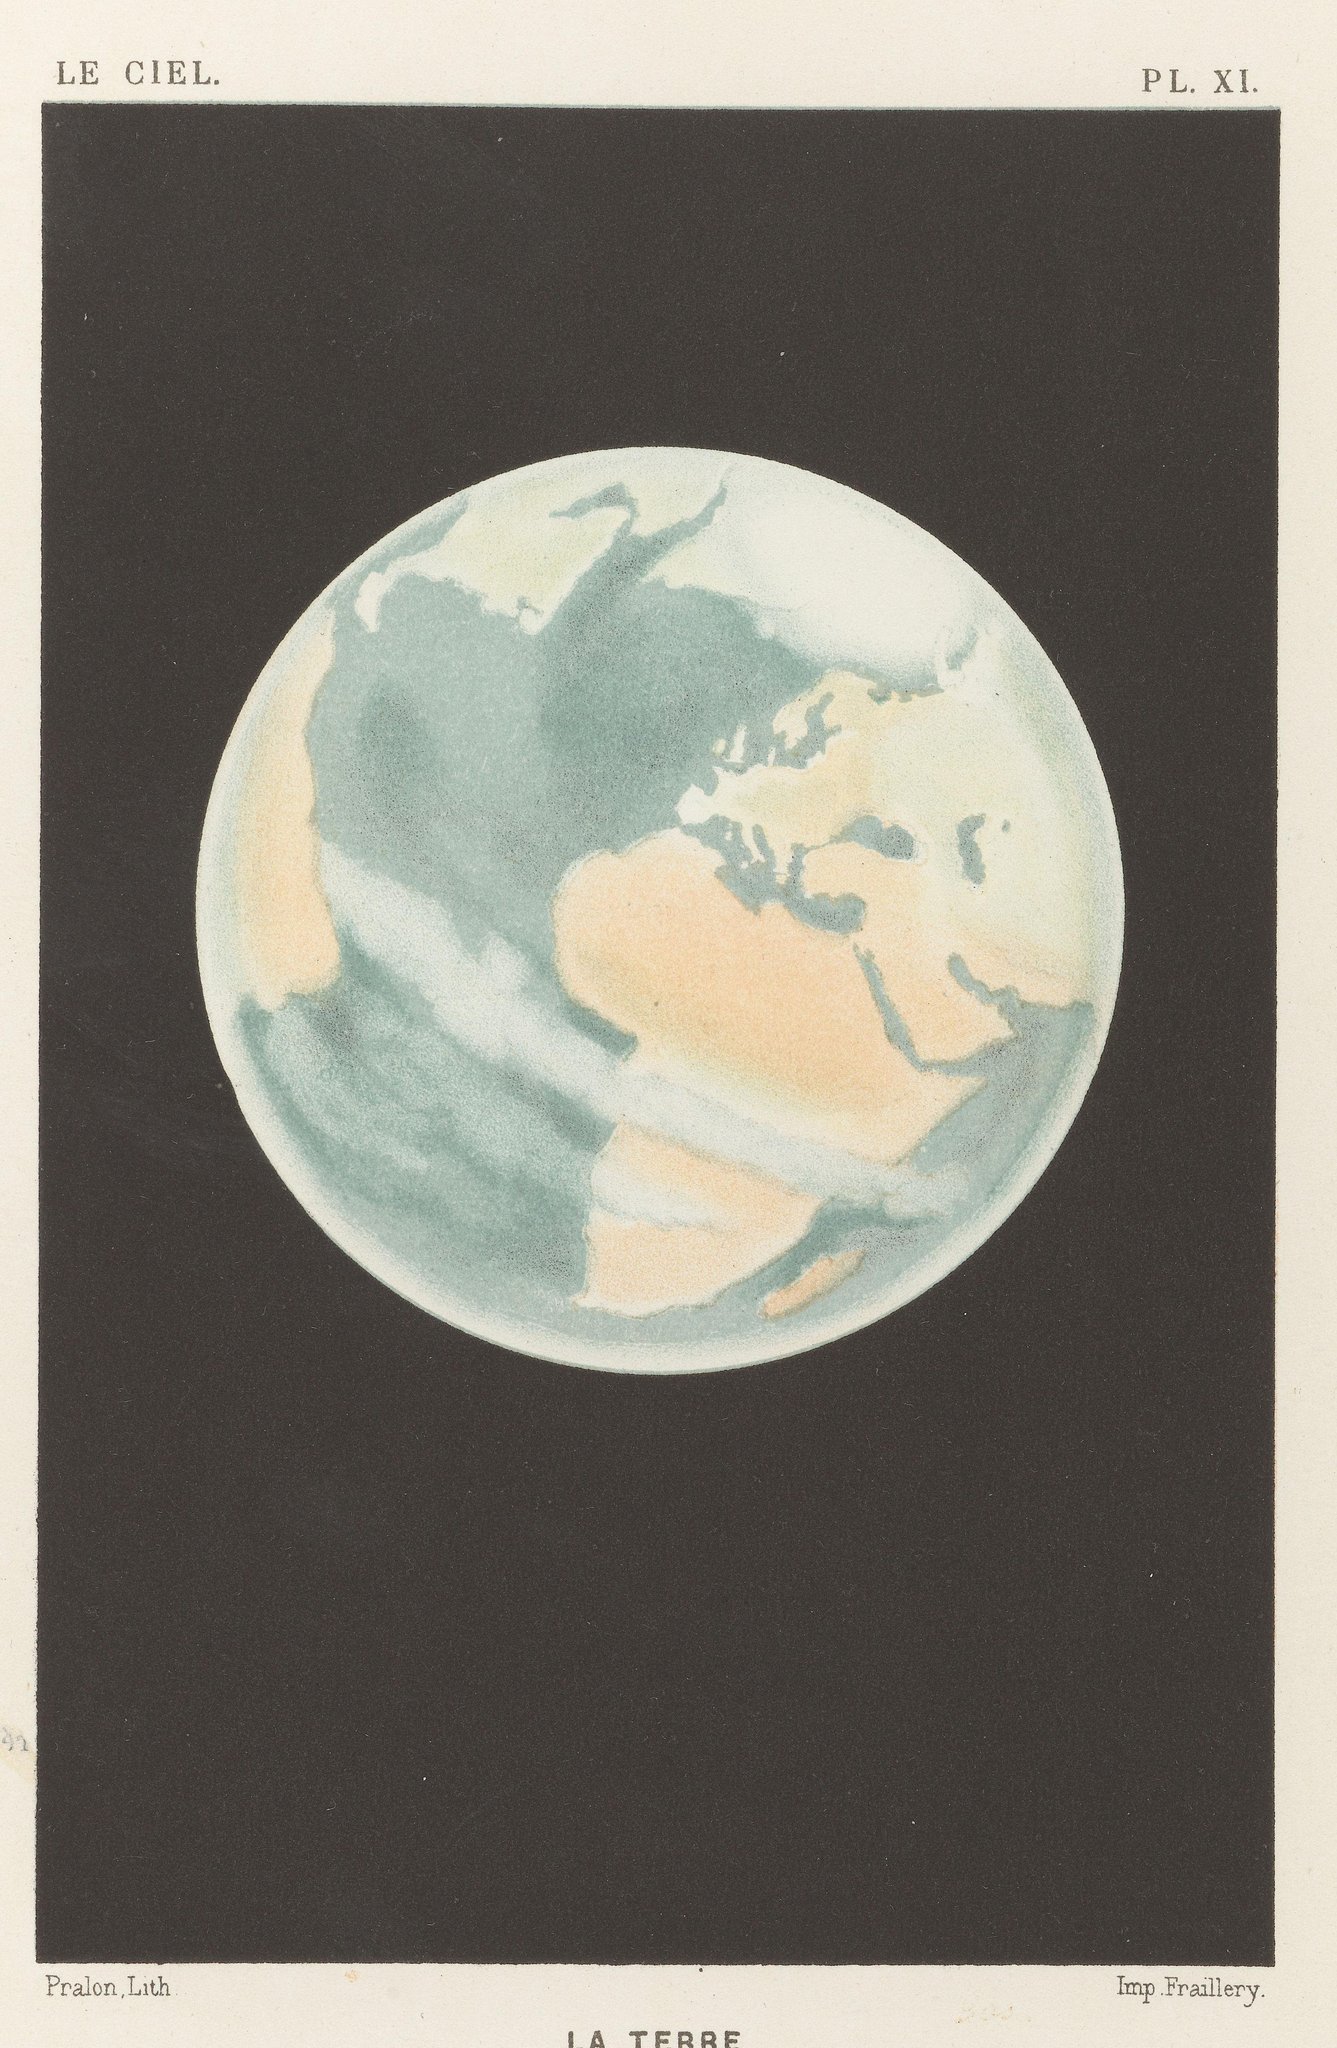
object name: print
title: La Terre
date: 1867-1877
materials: paper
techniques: lithograph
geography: paris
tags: earth, world as celestial body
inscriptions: number: ‘Pl. XI.’, inscription: ‘Vue dans l'espace, à l'époque du Solstice d'été.’